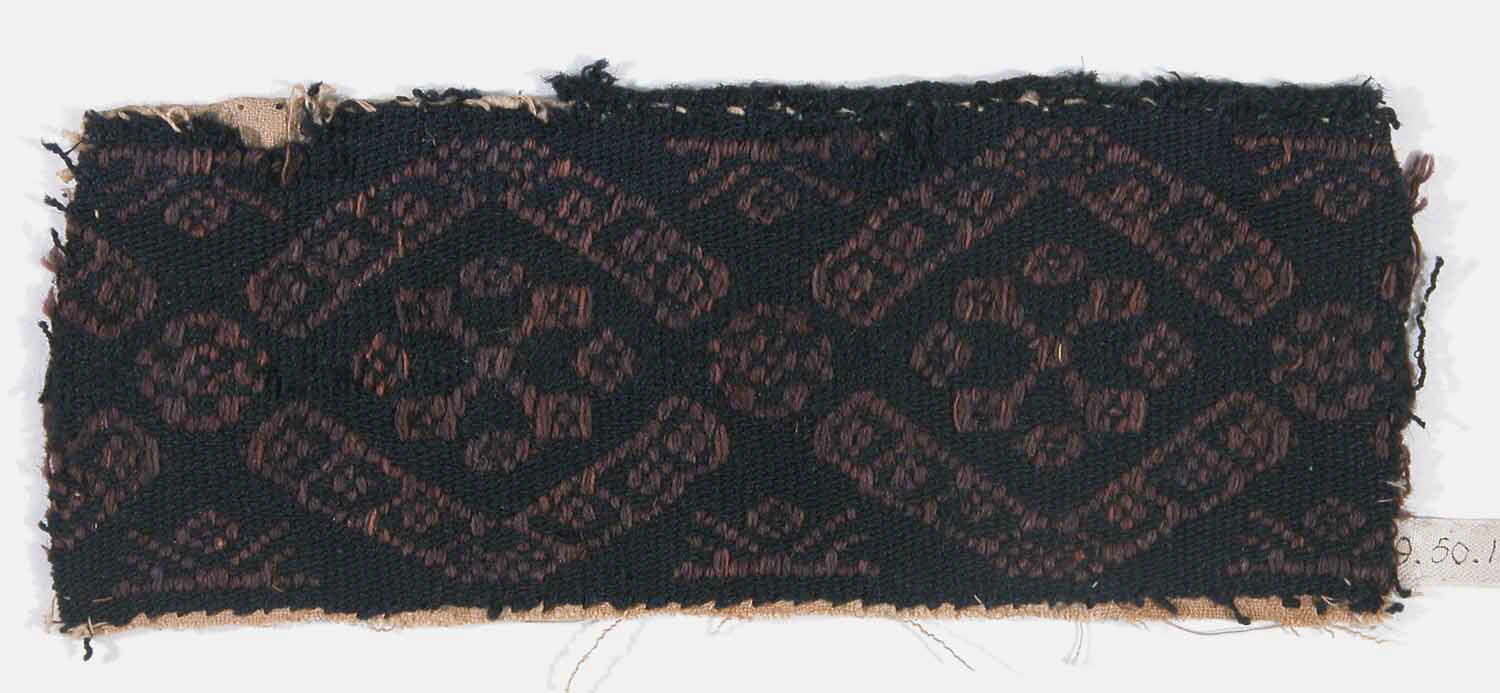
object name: band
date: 401-600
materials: linen, wool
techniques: weave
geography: egypt